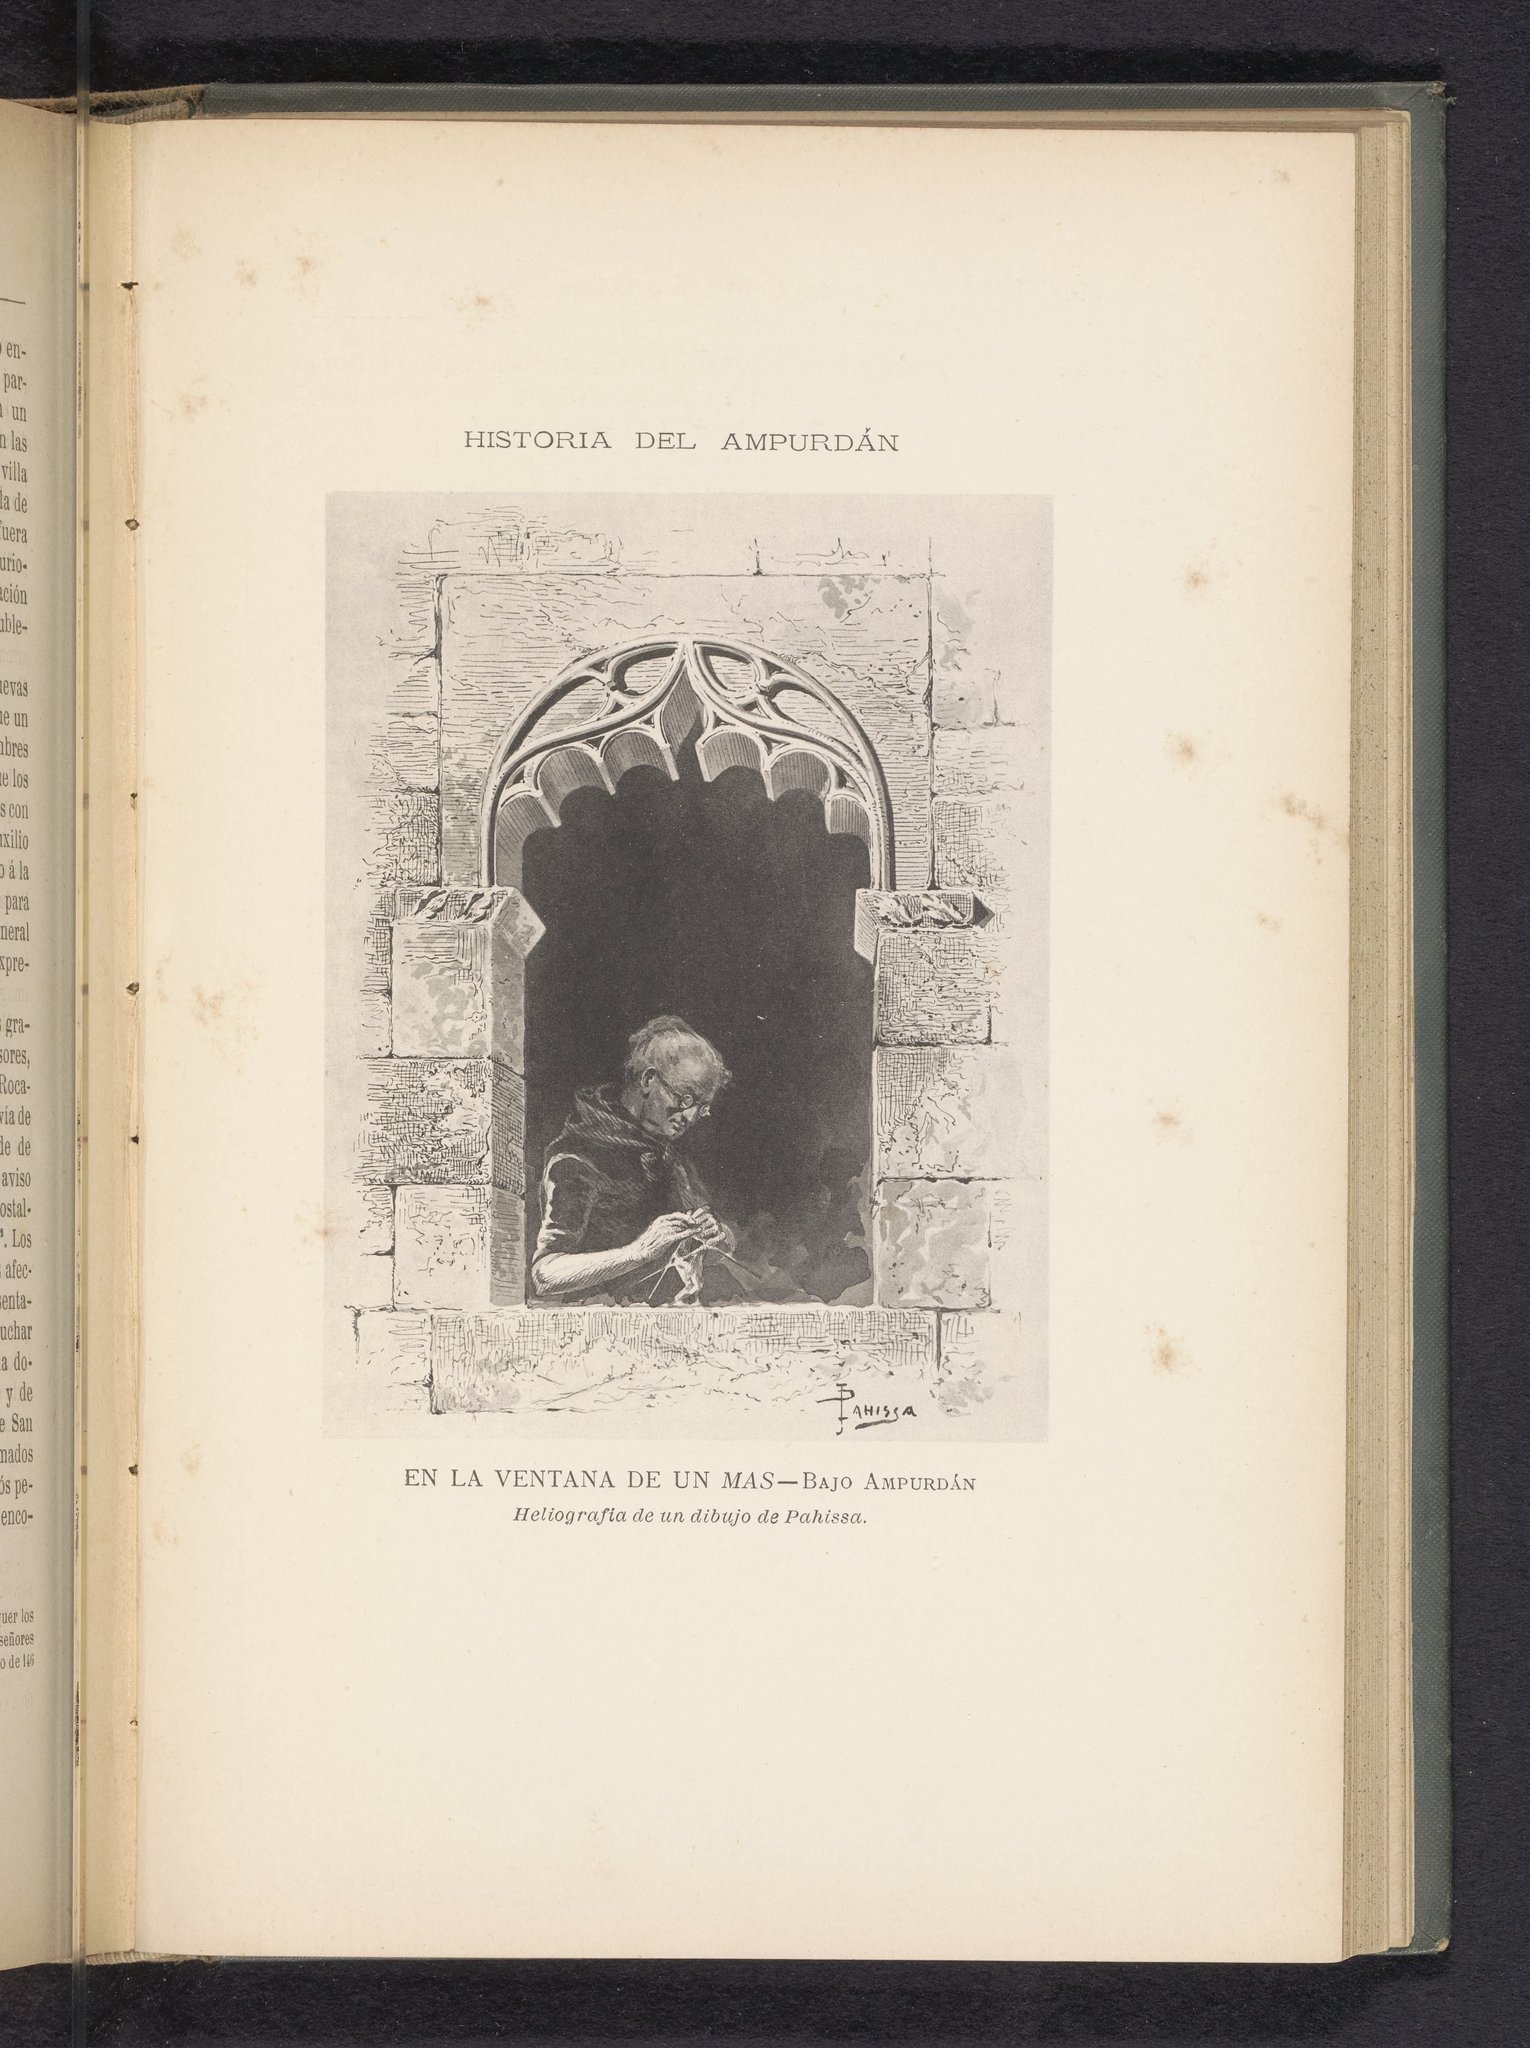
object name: page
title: Fotoreproductie van een tekening, voorstellende een figuur in een raam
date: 1873-1883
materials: paper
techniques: photograph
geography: catalonia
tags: human figure at (open) window, seen from outside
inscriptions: inscription: ‘Portal de Santa Catalina’